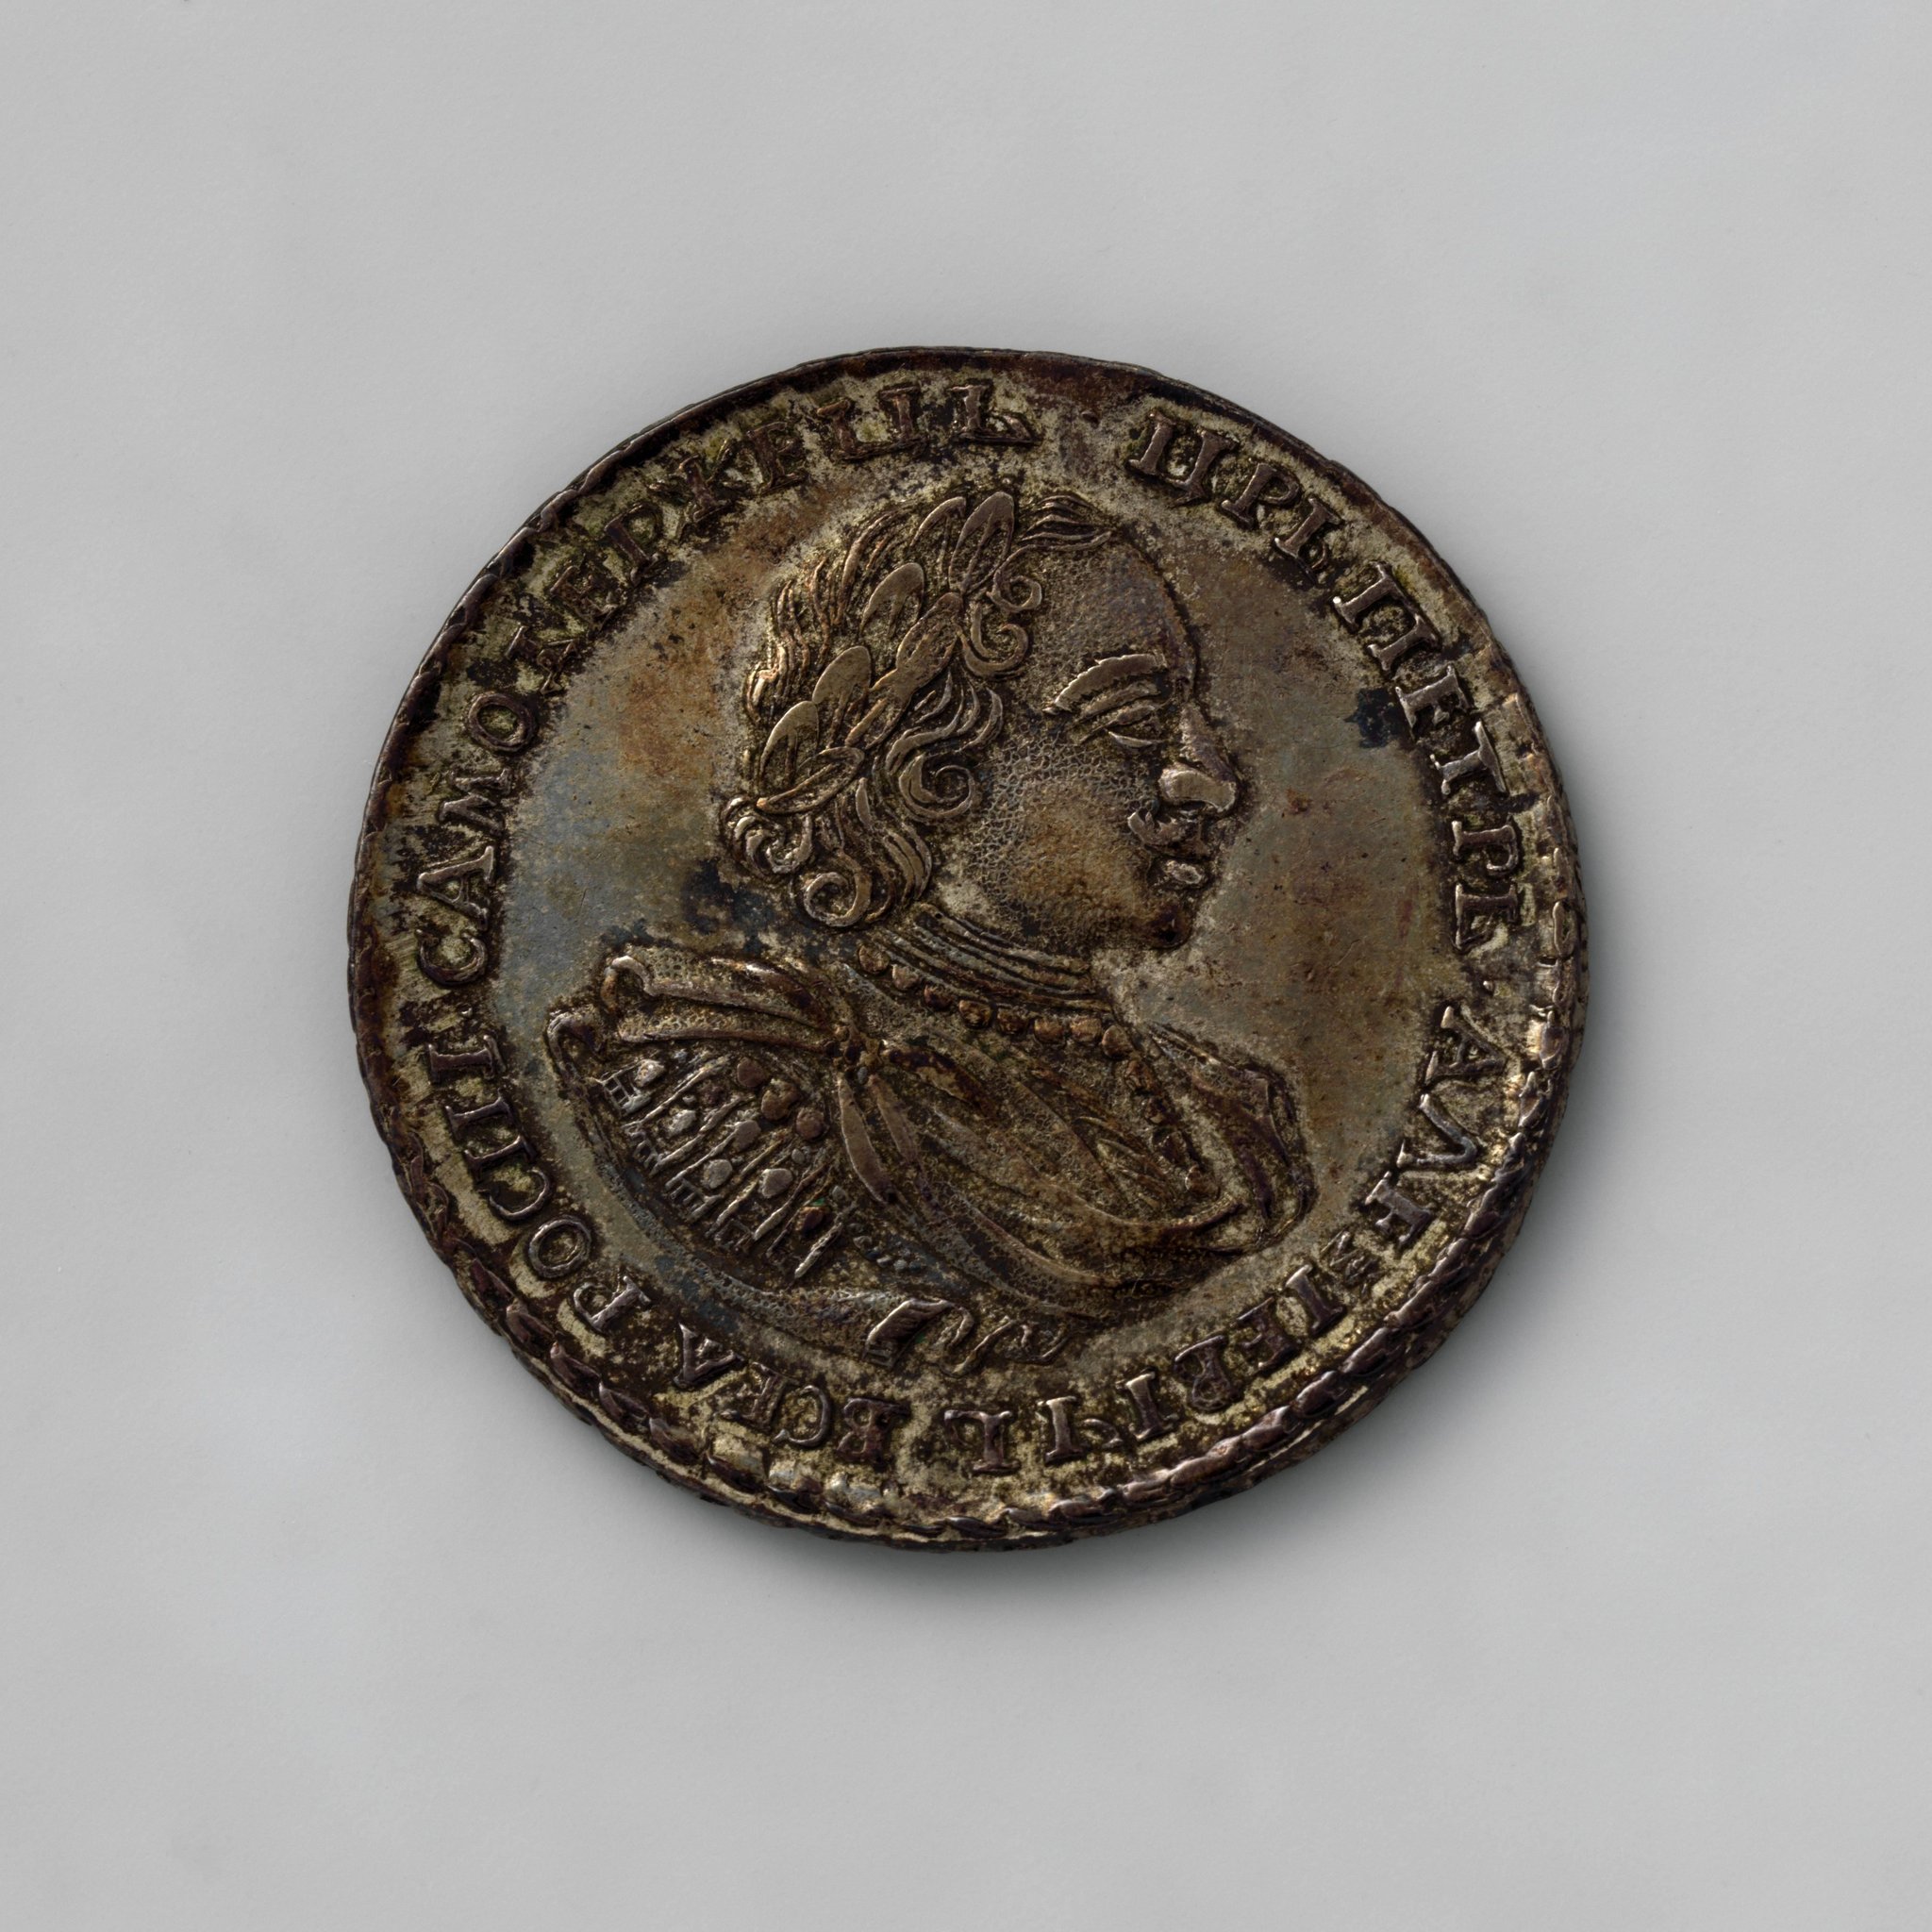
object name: coin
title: Rusland, czaar Peter I (de Grote), ½ roebel, 1701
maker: Anonymous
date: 1718-1722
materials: silver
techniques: striking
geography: sint-petersburg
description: Zilveren munt. Voorzijde: gelauwerd hoofd van de czaar naar rechts. Keerzijde: dubbelkoppige adelaar met in de poten scepter en rijksappel. Op beide koppen een kleine kroon, waarboven een grote kroon. Randschrift, waarin jaartal?